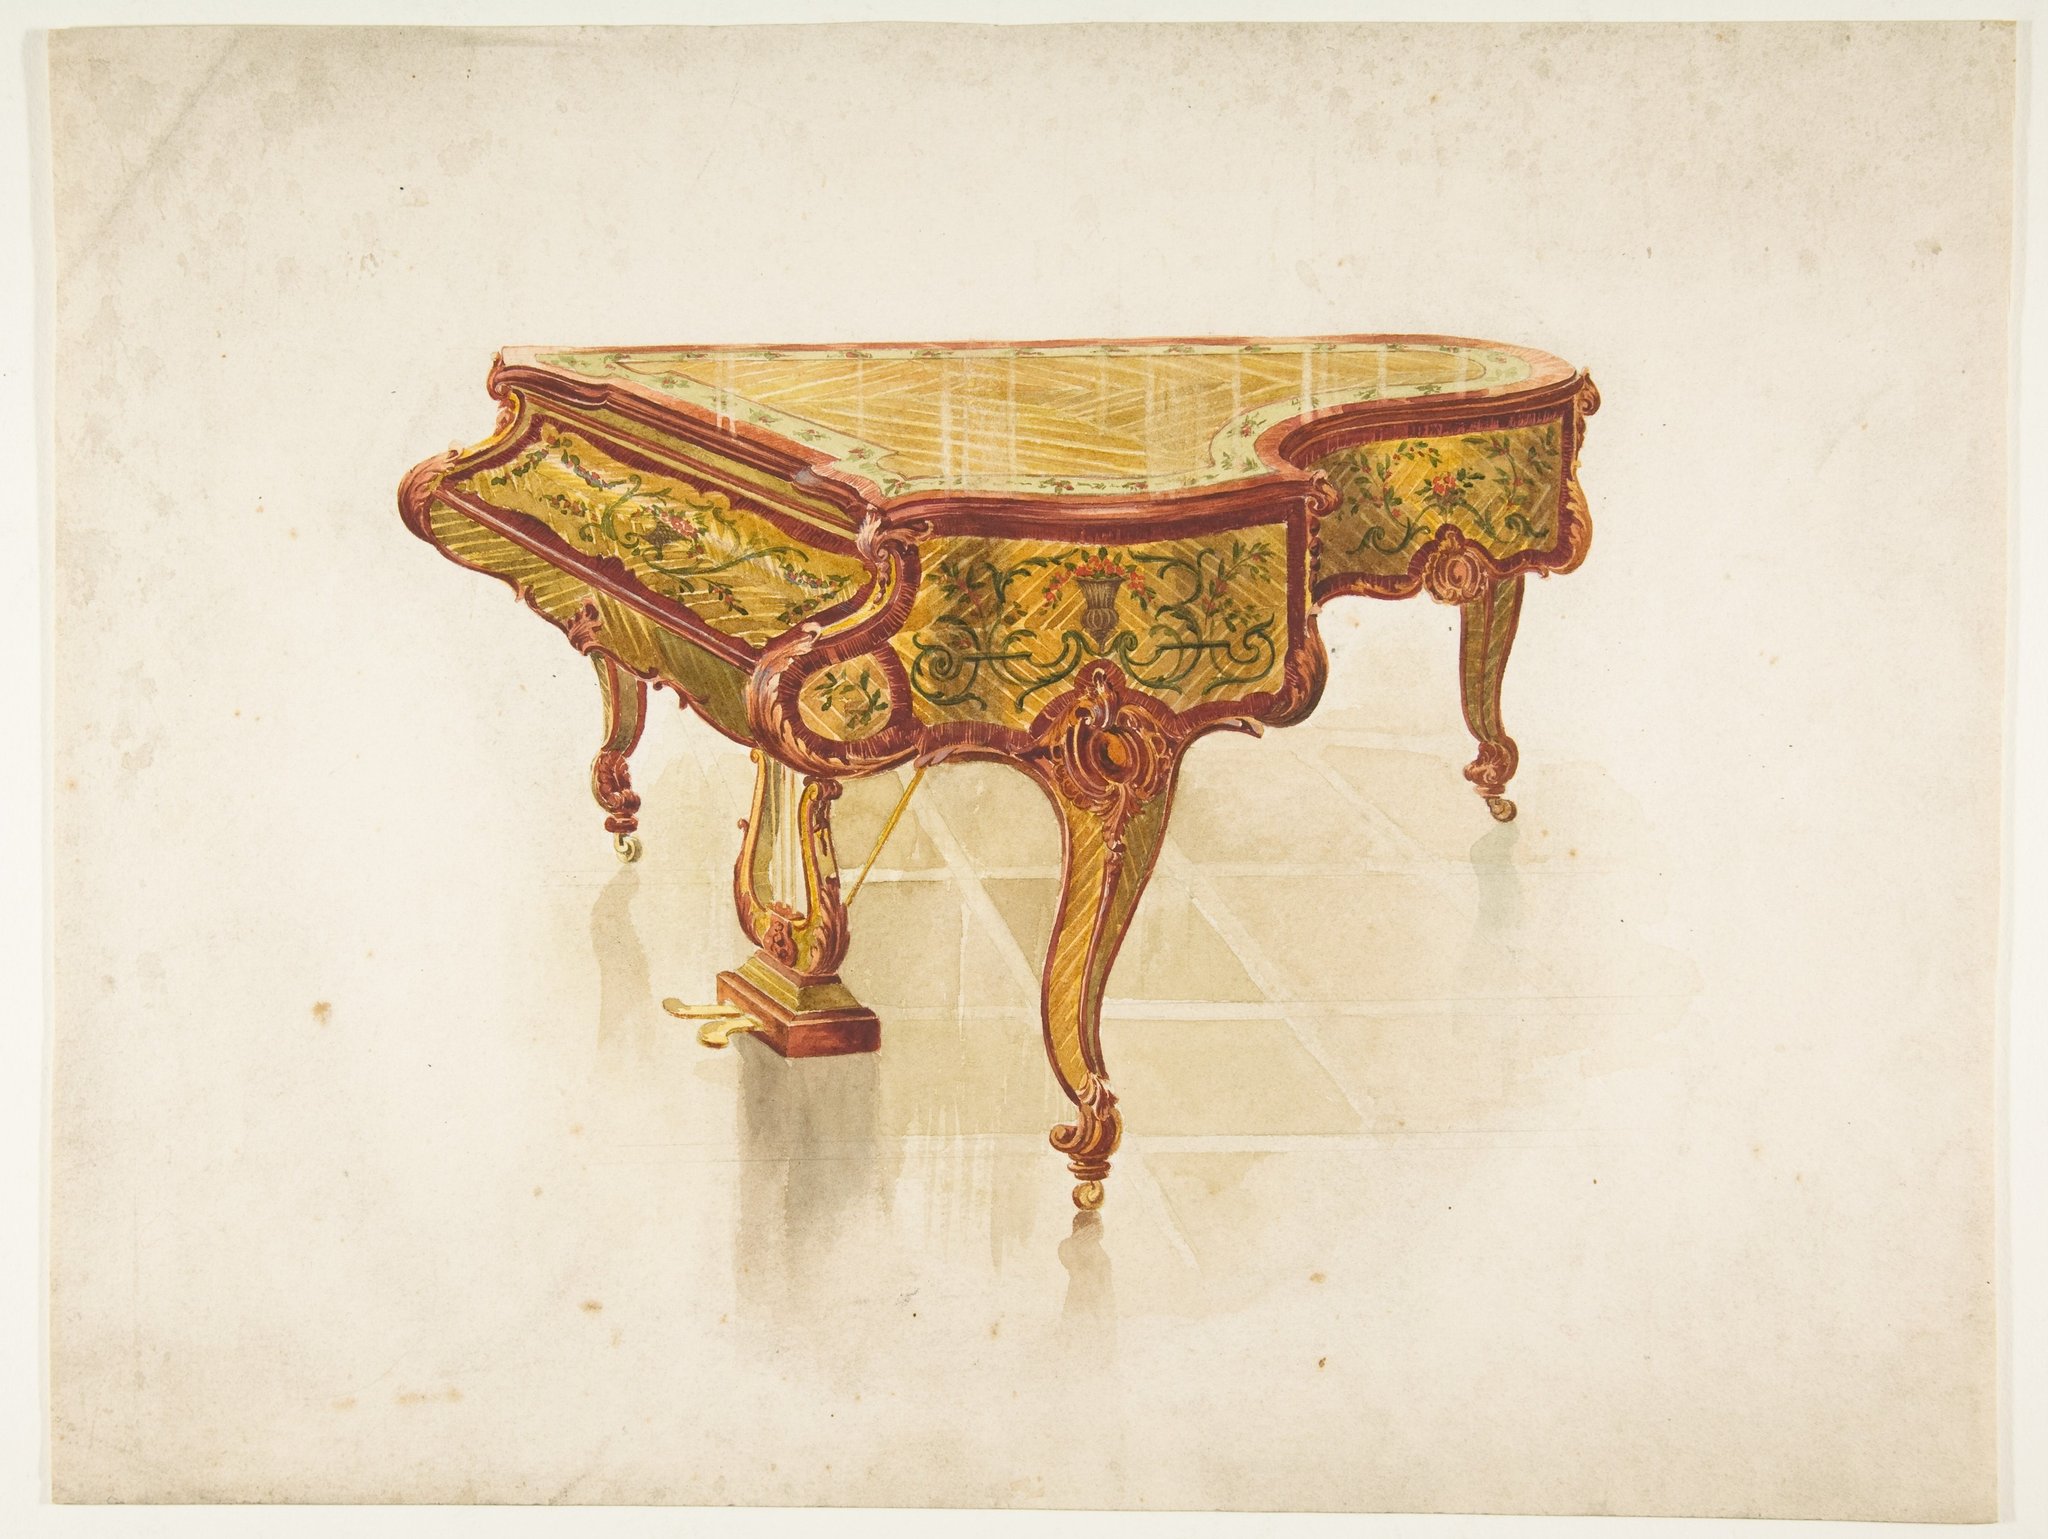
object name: drawing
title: Design for a Piano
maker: anonymous, french, 19th century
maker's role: artist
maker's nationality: french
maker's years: 1800-1900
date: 1801-1900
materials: graphite, watercolor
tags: pianos